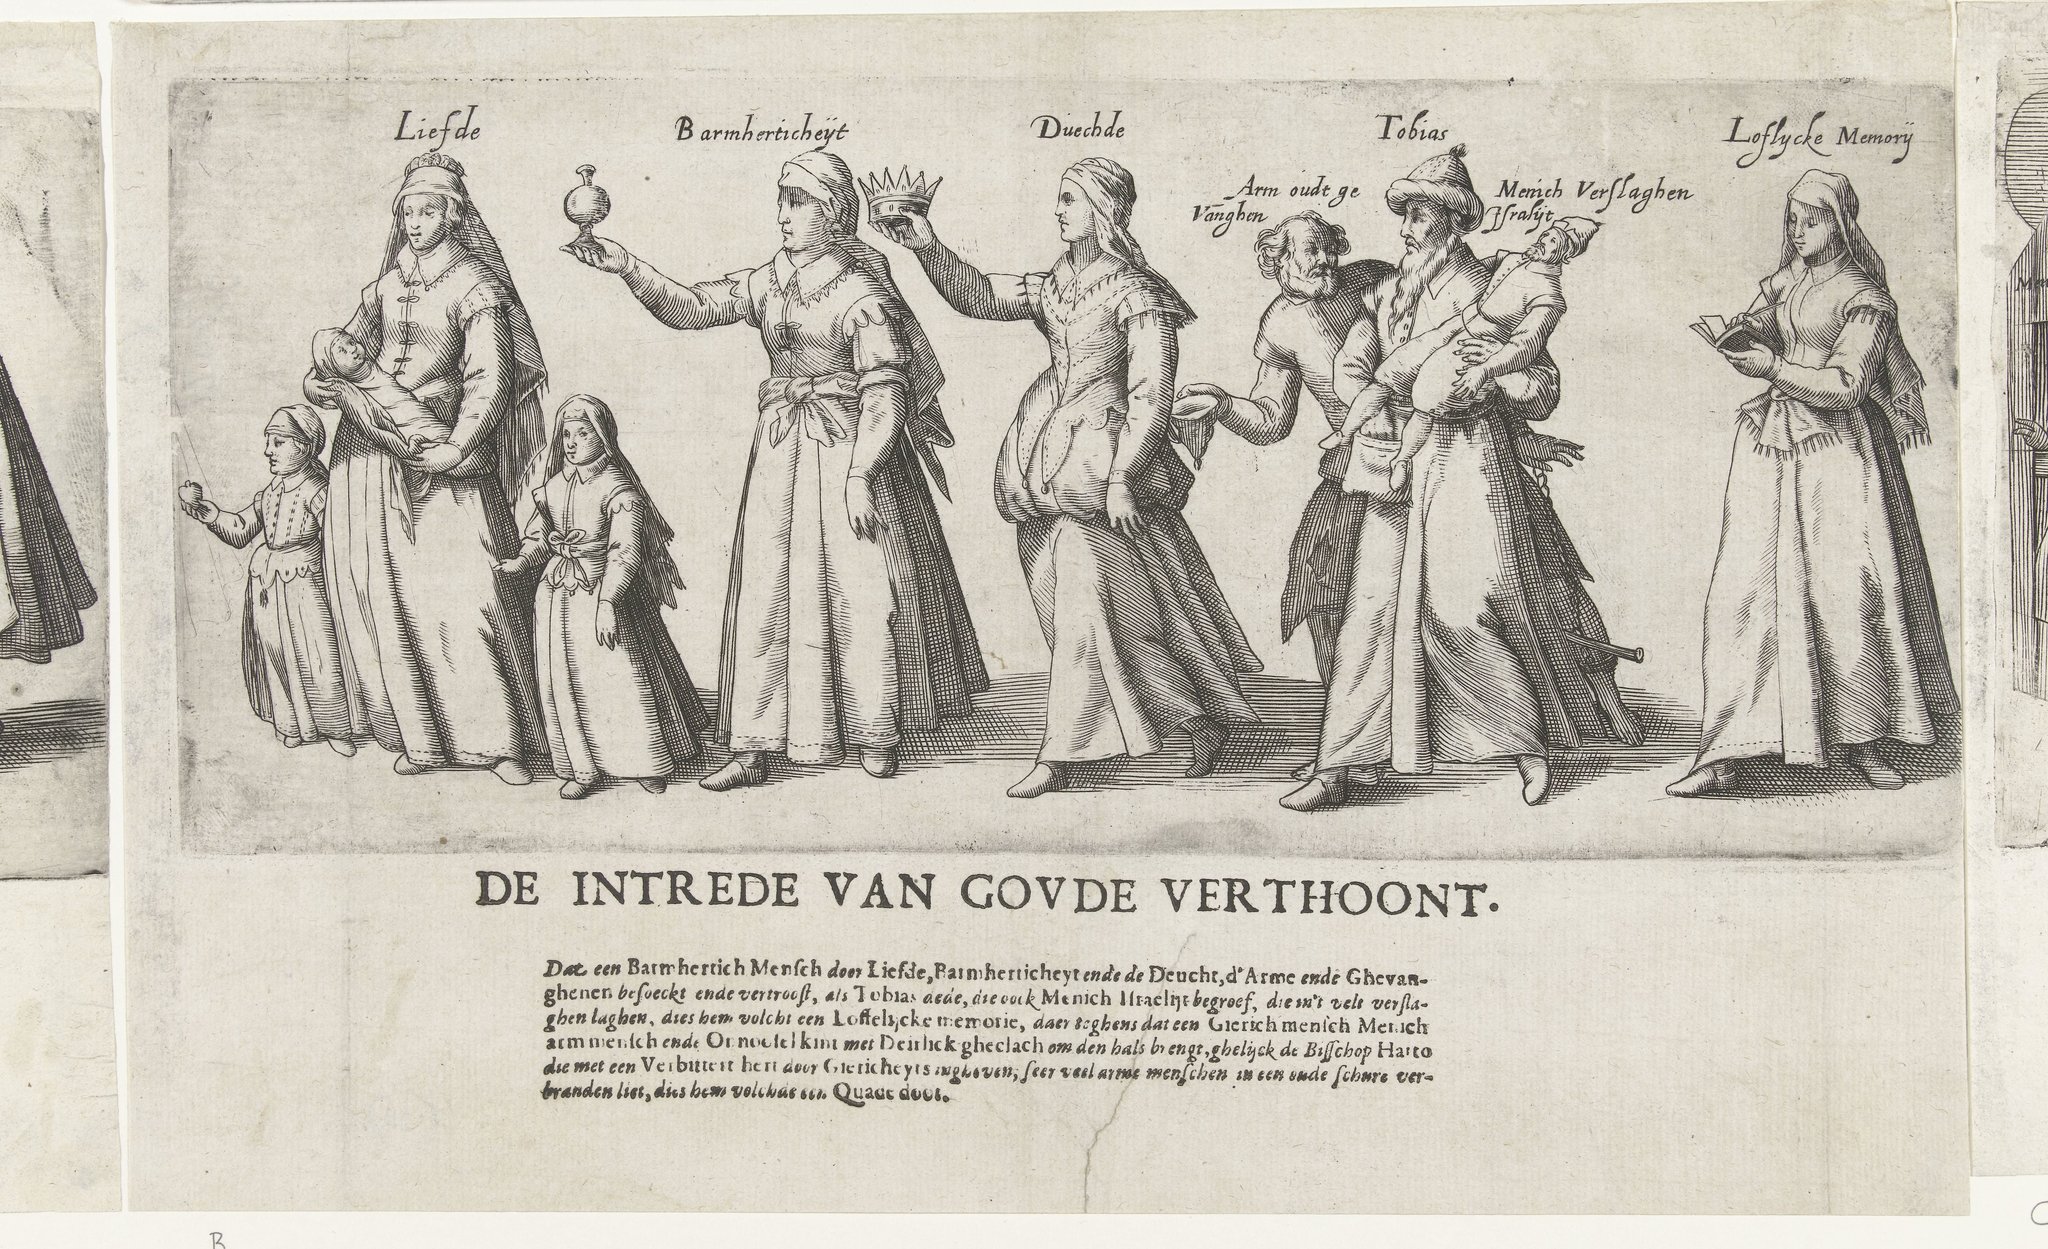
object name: print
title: Optocht door de rederijkerskamer De Goudsbloem uit Gouda (tweede deel), 1607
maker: Anonymous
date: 1607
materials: paper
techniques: engraving, letterpress printing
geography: northern netherlands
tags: chamber of rhetoric (dutch: 'rederijkerskamer'), festivities (+ parade, pageant, cavalcade ~ festive activities), haarlem, gouda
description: Gebruikt als illustratie in: Const-thoonende ivweel, by de loflijcke stadt Haerlem, ten versoecke van Trou moet blijcken, in't licht gebracht. : Waer inne duydelick verclaert ende verthoont wordt alles wat den mensche mach wecken om den armen te troosten, ende zijnen naesten by te staen. : In twaelf spelen van sinne ... in redenrijck naar de volgende voorgegevene caerte van 't speel-korenken, Zacharias Heyns, Zwolle 1607. Los fragment, bedoeld om samen met de andere delen tot een fries gemonteerd te worden.